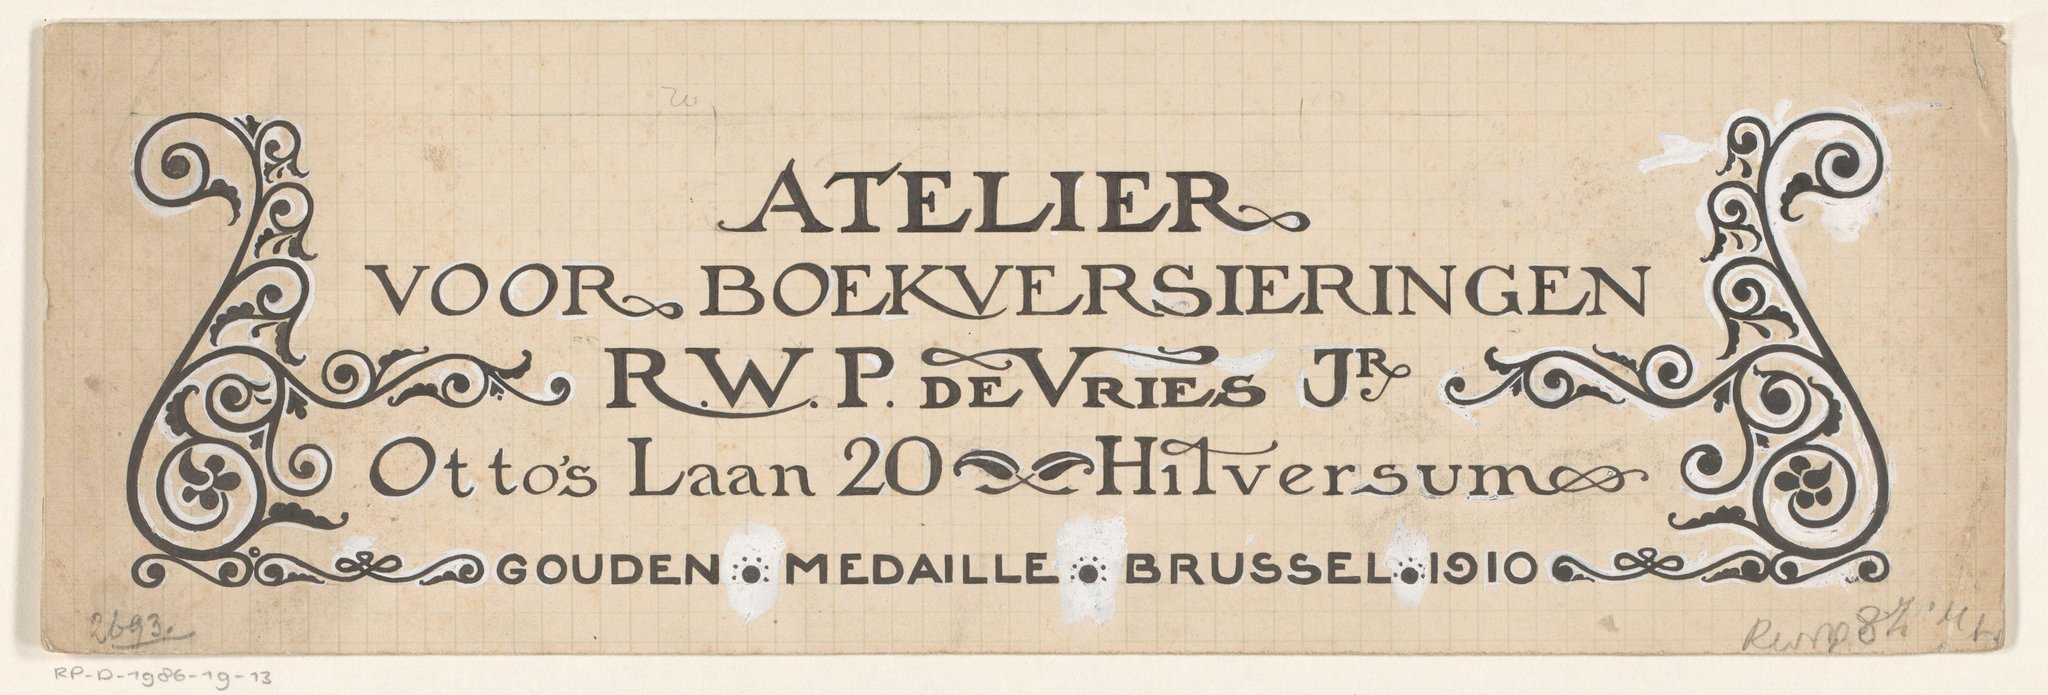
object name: design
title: Vignet van Atelier voor Boekversieringen te Hilversum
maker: reinier willem petrus de vries (1874-1953)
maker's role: draughtsman, print maker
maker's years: 1874-1953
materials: paint, ink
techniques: brush, pen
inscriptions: collector's mark: ‘R:MVS.’